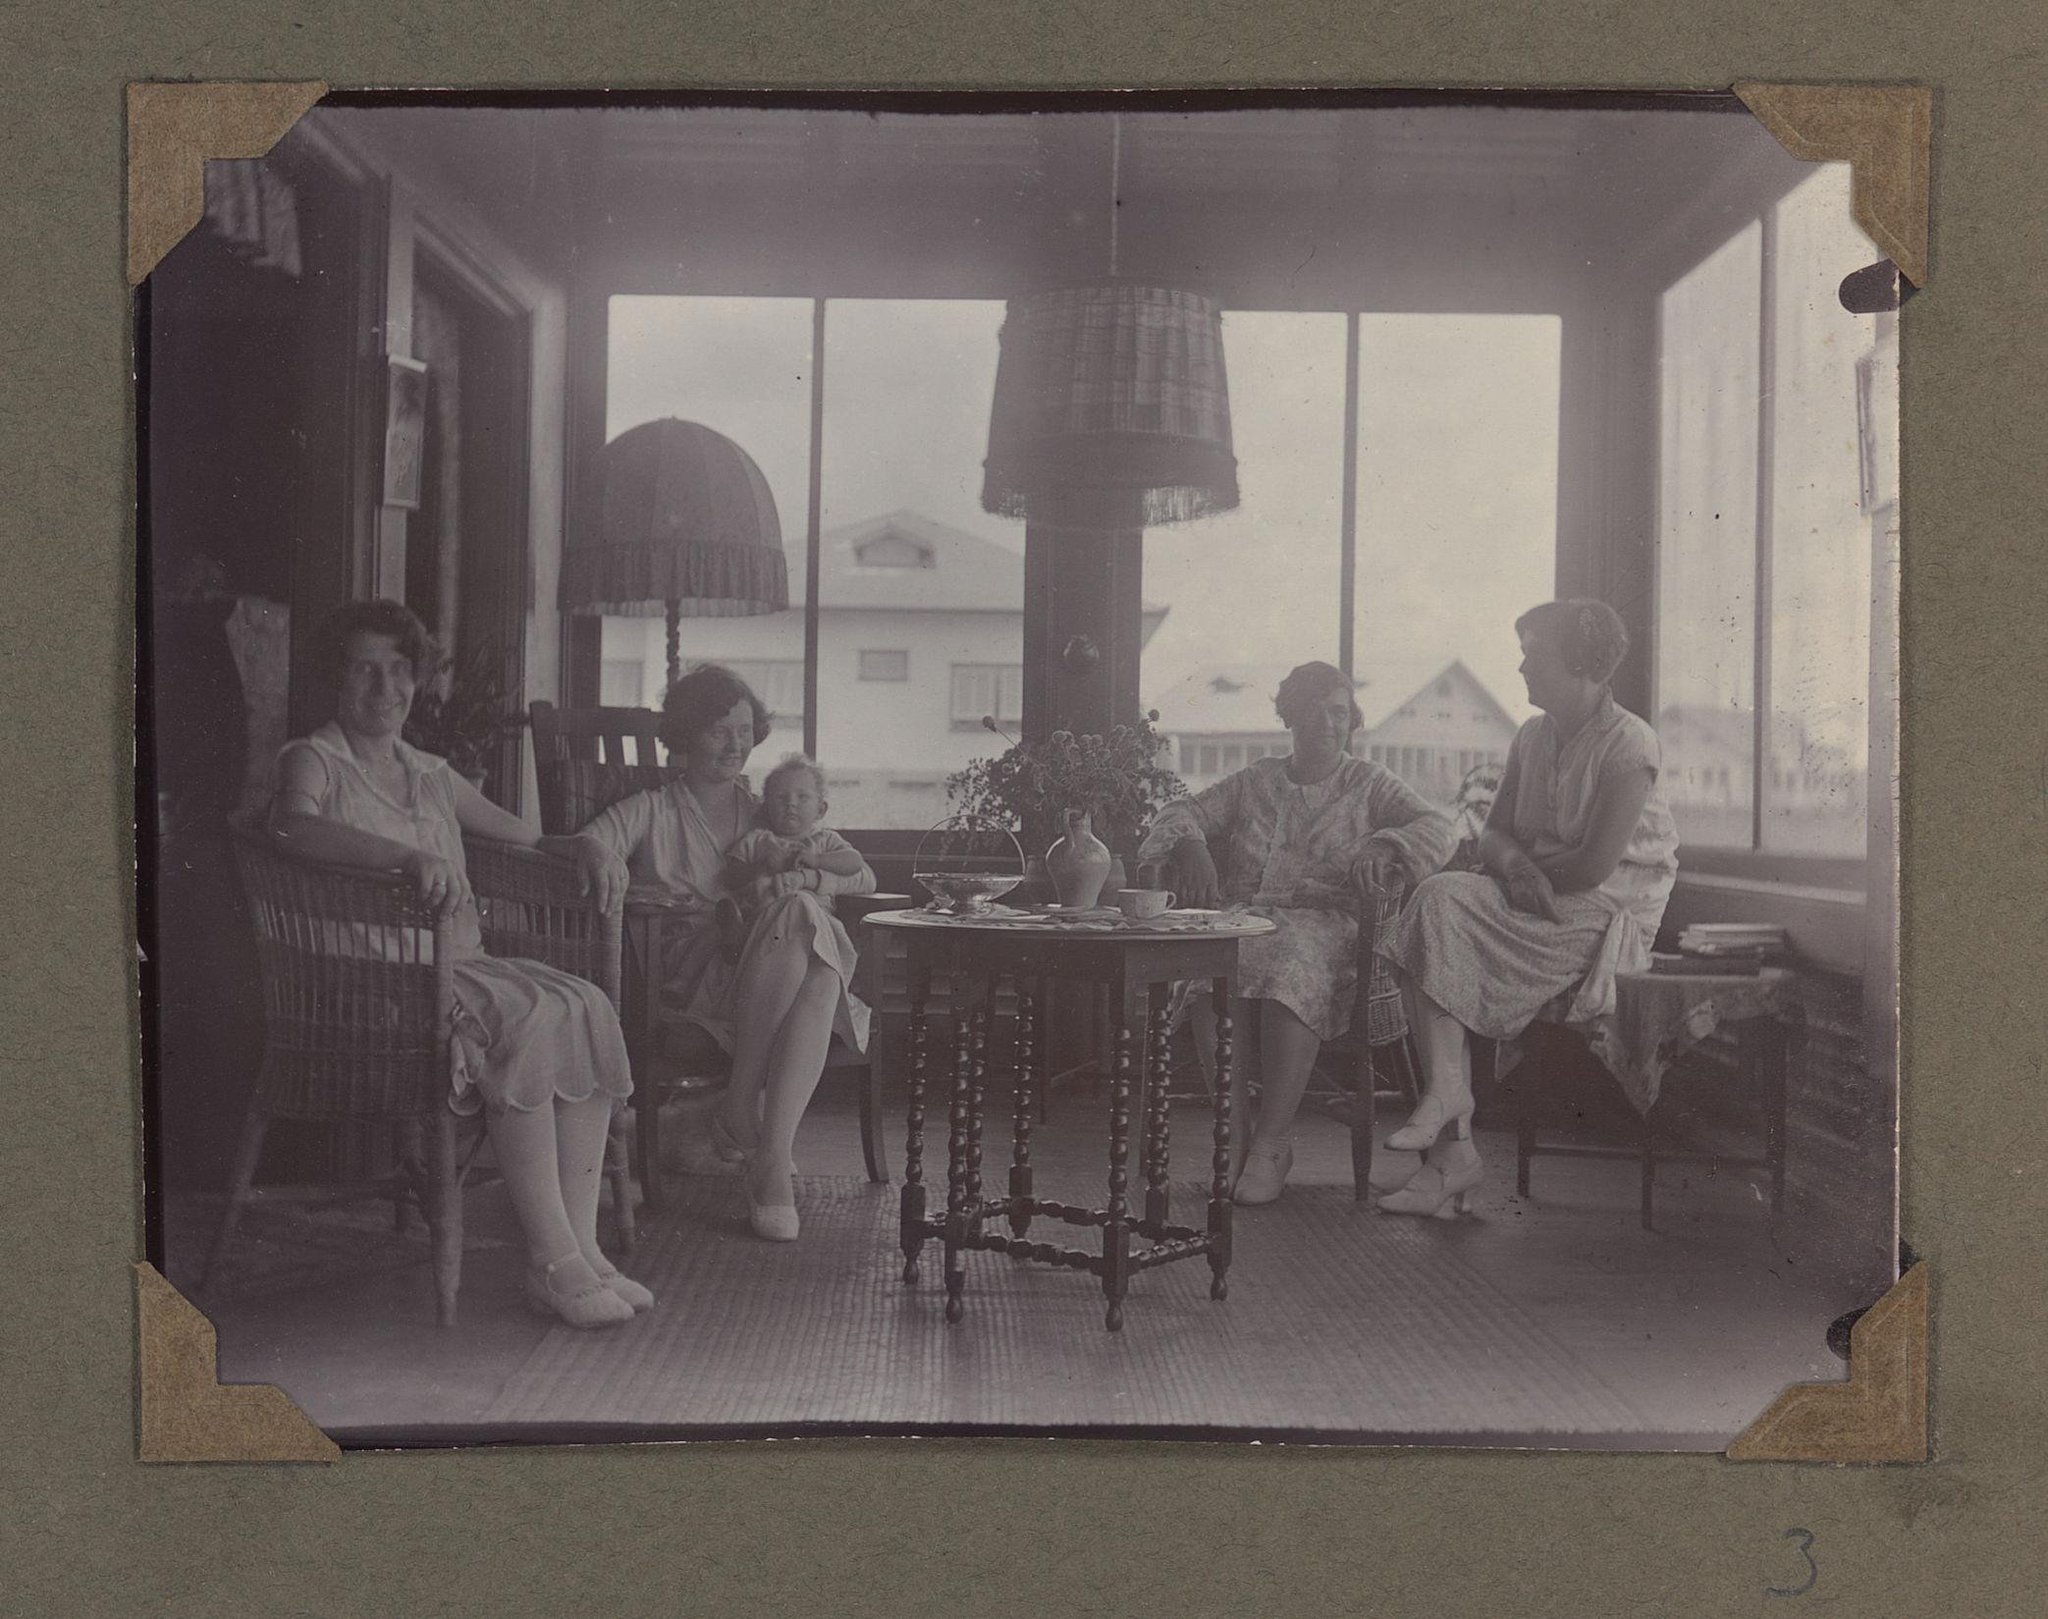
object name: photograph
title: Familiefoto van een groep vrouwen te Moengo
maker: Anonymous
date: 1925-1927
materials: photographic support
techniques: photography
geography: suriname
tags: jetten, familie, moengo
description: Familiefoto van Edith Jetten met enkele vrouwen in het huis te Moengo. Foto op een bladzijde van een los albumblad. Onderdeel van het ensemble met foto's van de familie van ingenieur Jetten in de mijnbouwstad Moengo in Suriname.